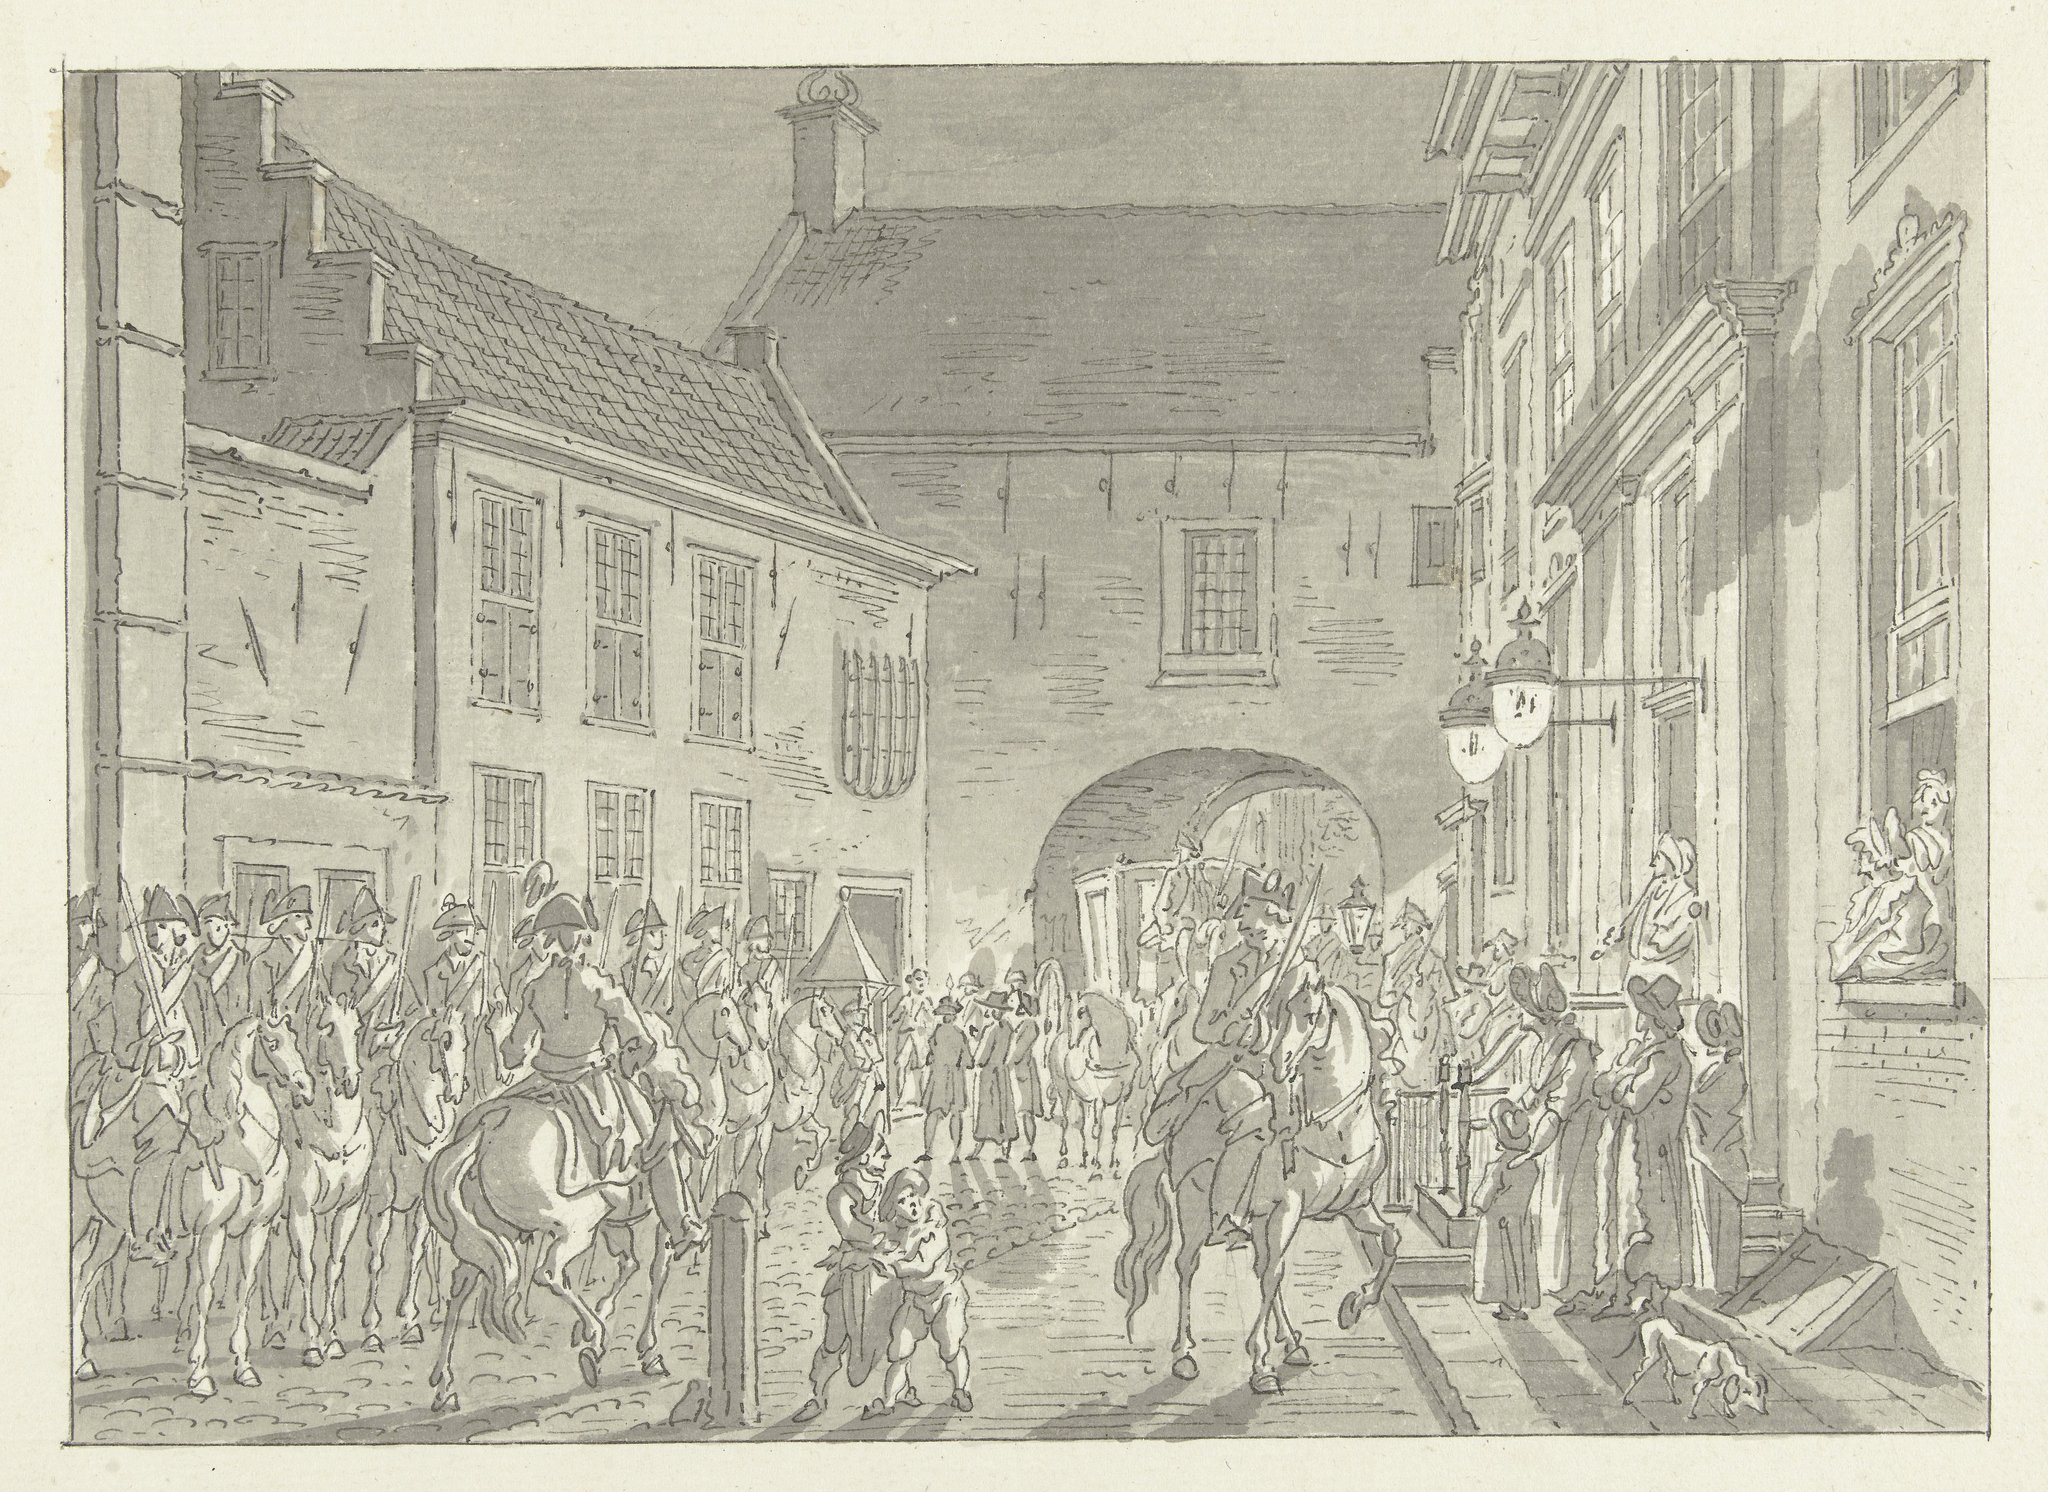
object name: drawing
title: L.P. van de Spiegel naar de Gevangenpoort gebracht, 1795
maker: jan bulthuis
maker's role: draughtsman, print maker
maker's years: 1750-1801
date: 1796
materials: paper, pencil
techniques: brush, pen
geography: netherlands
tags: transport (of arrested person), imprisonment, arrest (of criminal)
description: De voormalige raadspensionaris Laurens Pieter van de Spiegel wordt 's avonds naar de Gevangenpoort te Den Haag overgebracht, 14 oktober 1795. Spiegel stapt uit het rijtuig, op de voorgrond links een escorte soldaten te paard.